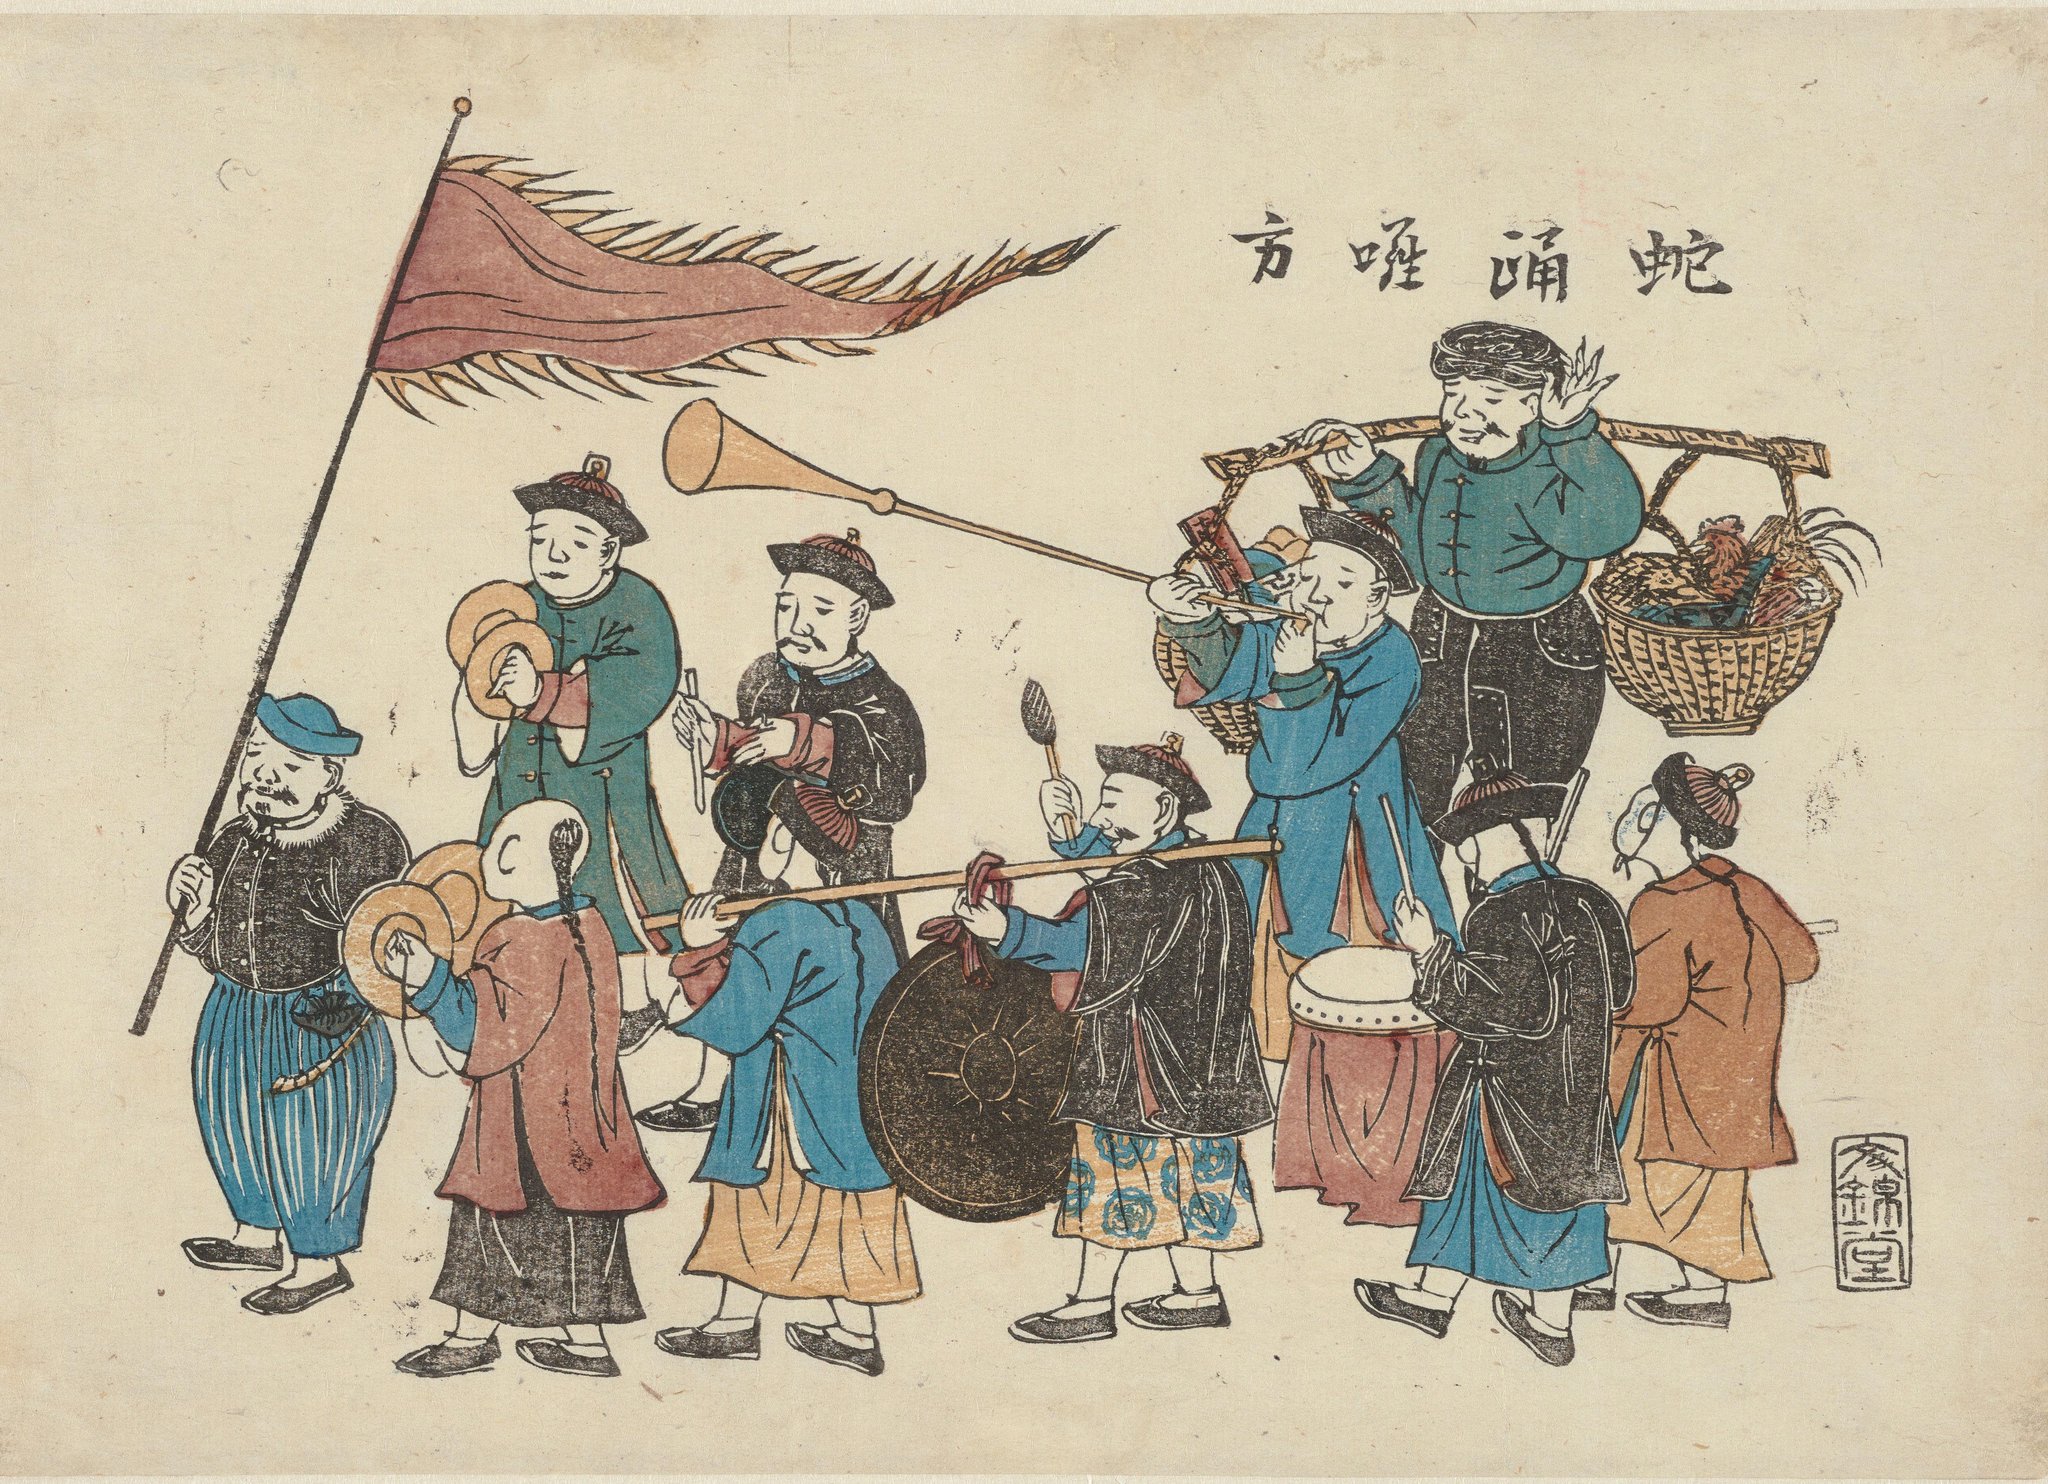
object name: print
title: Ja odori hayakata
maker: Anonymous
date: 1800-1840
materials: paper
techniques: woodcut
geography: nagasaki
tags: brass band, street band, asiatic races and peoples (with name)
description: Musicerend gezelschap bij de Drakendans. Groep musicerende mannen, met voorop een vaandel drager. (Nagasaki-e)